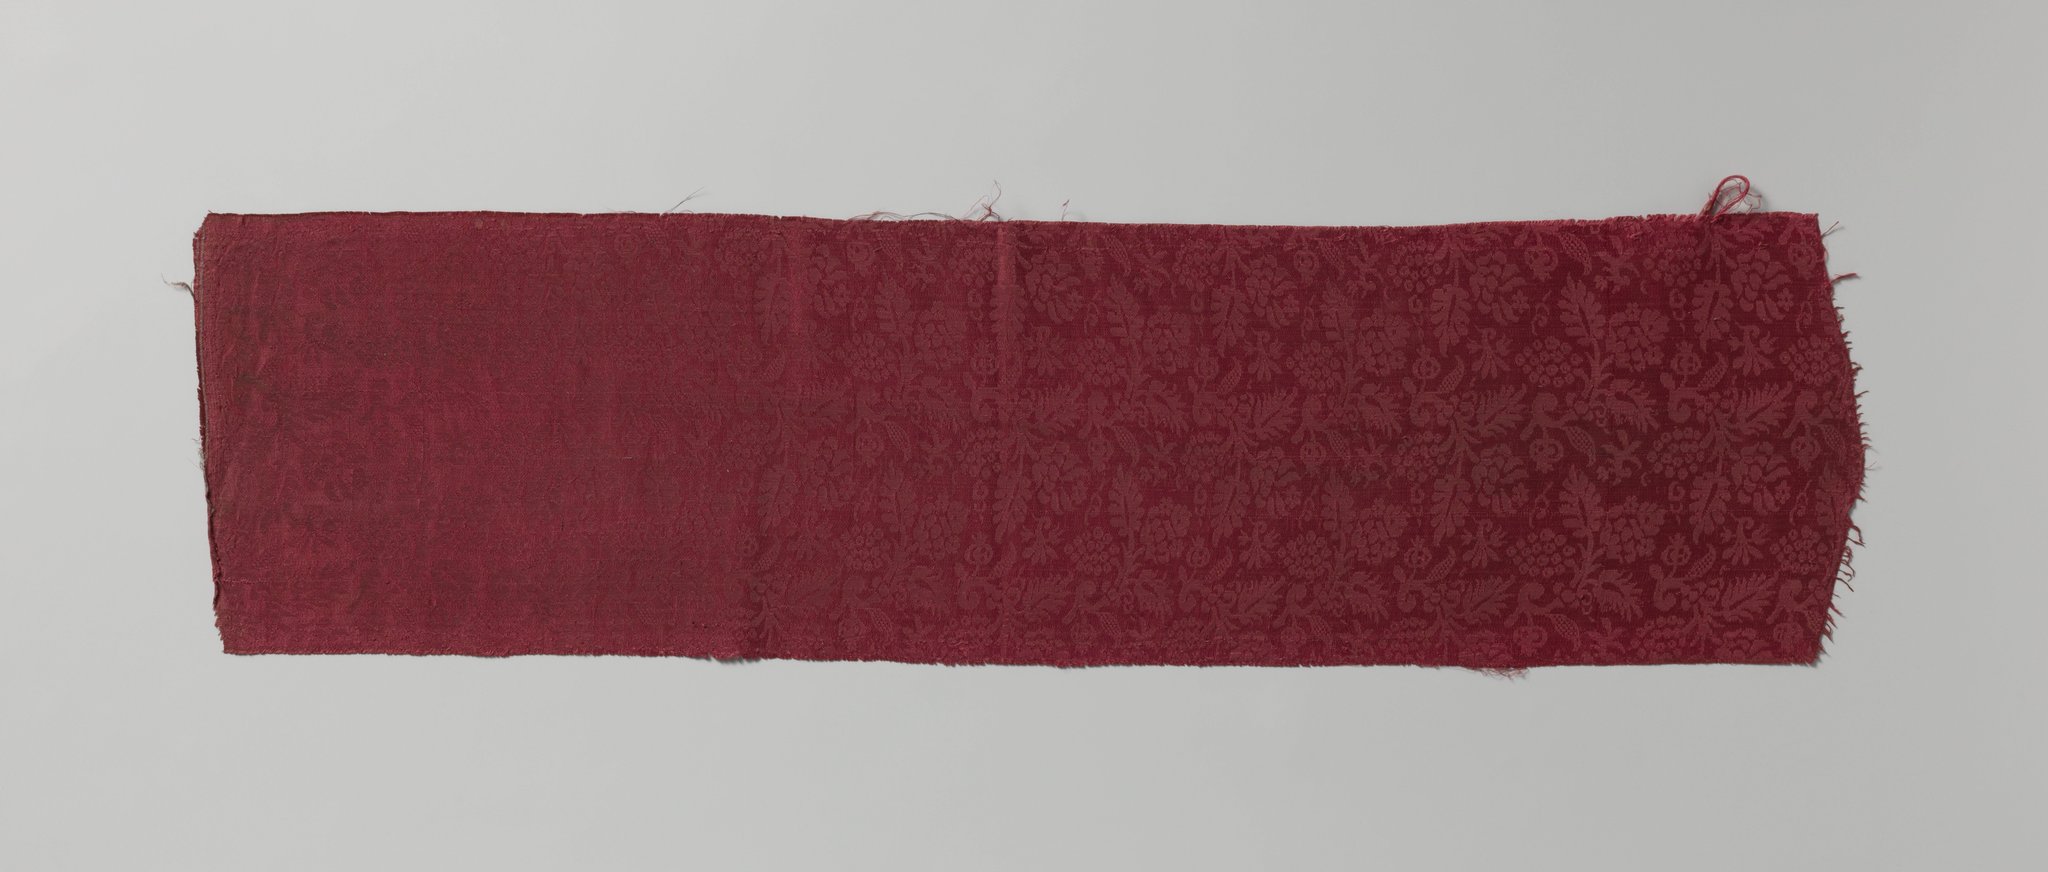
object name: zijdedamast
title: Fragment rood zijdendamast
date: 1615-1630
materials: silk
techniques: damask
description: Fragment rood zijdendamast met een patroon van bloemen en bladeren.